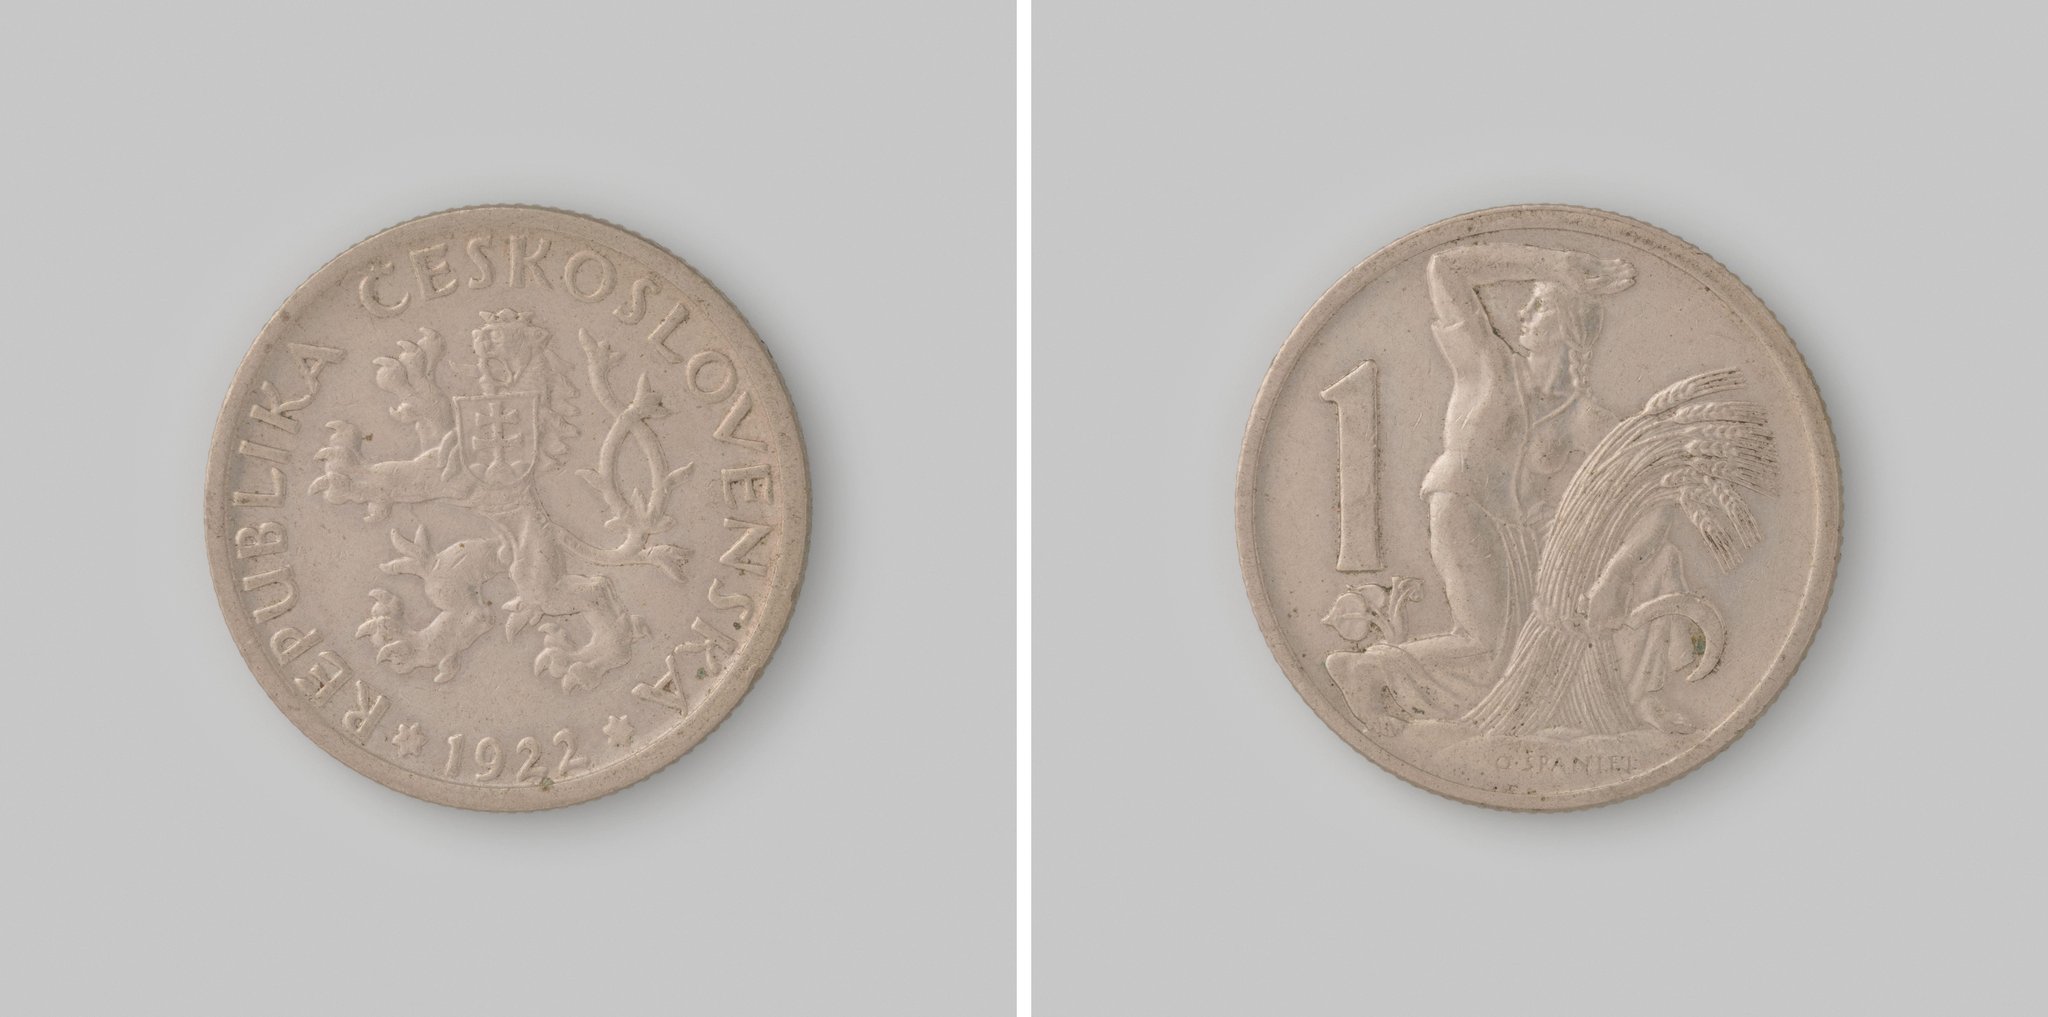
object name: coin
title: Tsjechoslowakije, koruna, 1922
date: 1922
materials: nickel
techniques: striking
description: Koper-nikkelen munt. Voorzijde: klimmende leeuw met dubbele staart naar links met op zijn borst een wapenschild. Jaartal onderaan in omschrift. Keerzijde: geknielde vrouw naar rechts met zeis en voor zich korenaren en achter zich een tak met bladeren. Links van haar waarde-aanduiding: 1. Kartelrand.